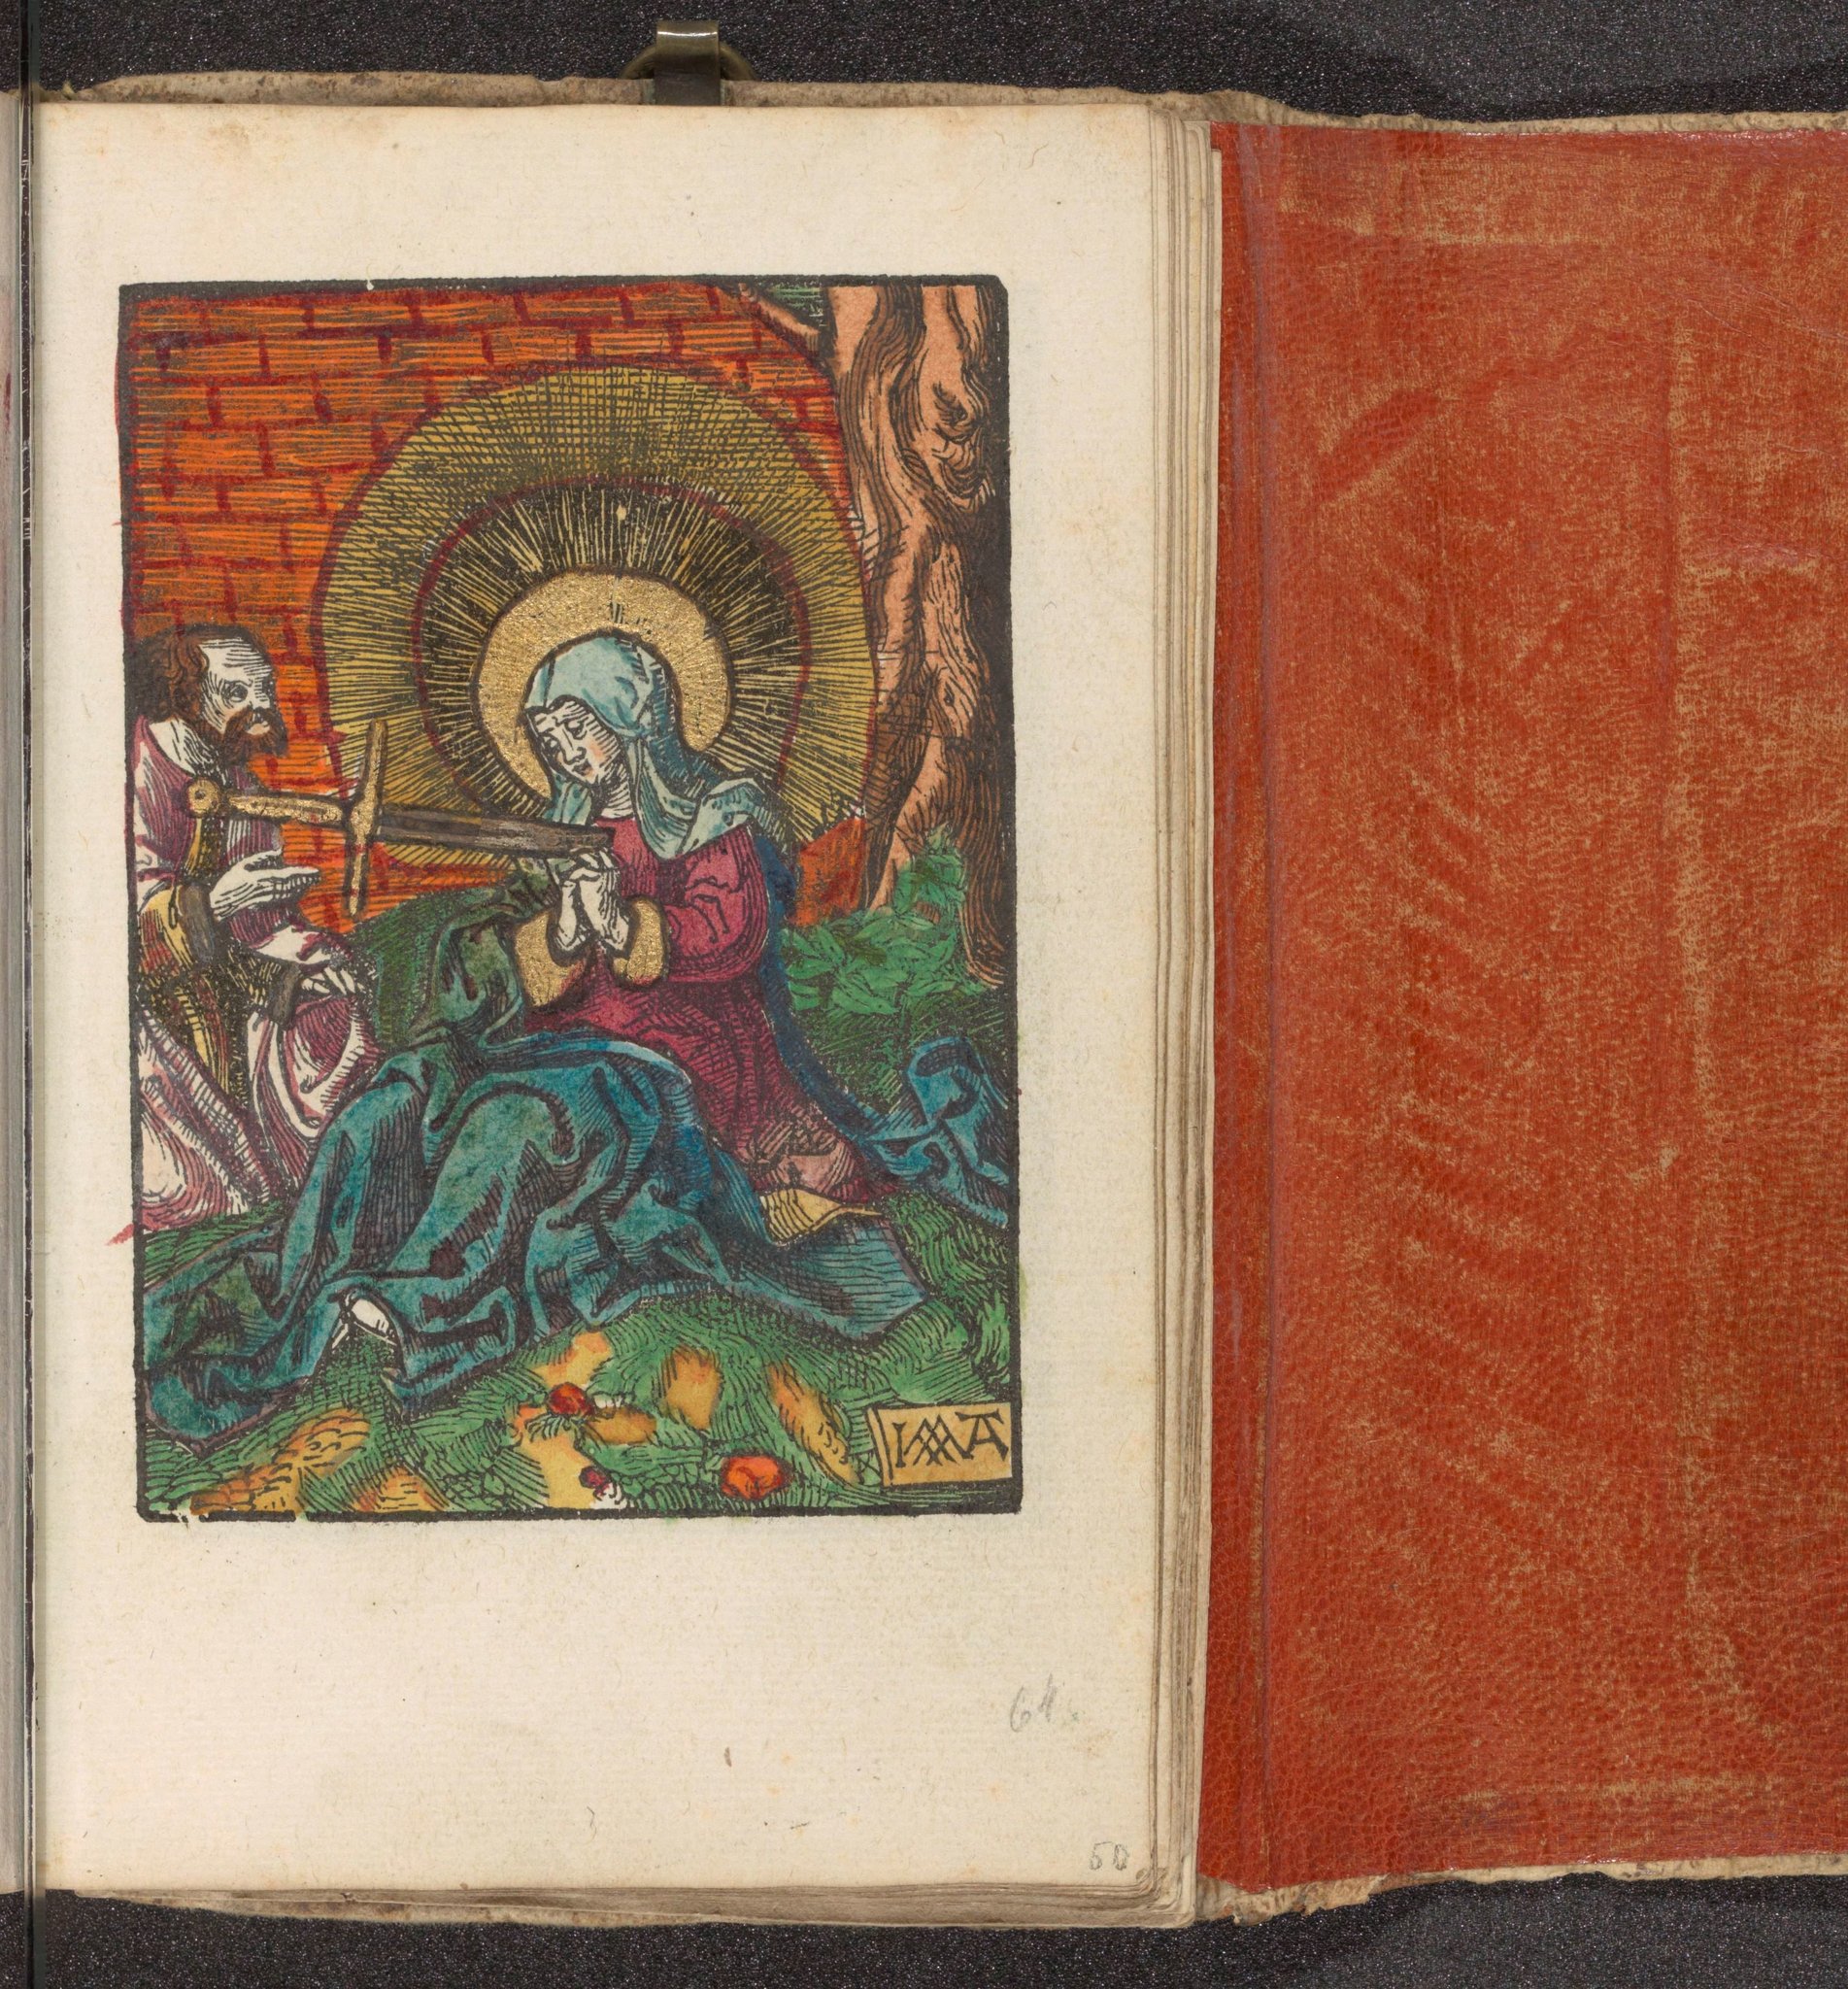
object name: album leaf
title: Stomme Passie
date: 1520-1521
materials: paper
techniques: hand coloring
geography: amsterdam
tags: book in which illustrations are essential, mary pierced by a sword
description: Maria zit met gevouwen handen op de grond. Haar hart wordt doorboord met een zwaard. Jozef zit naast haar. Prent maakt deel uit van een boek.